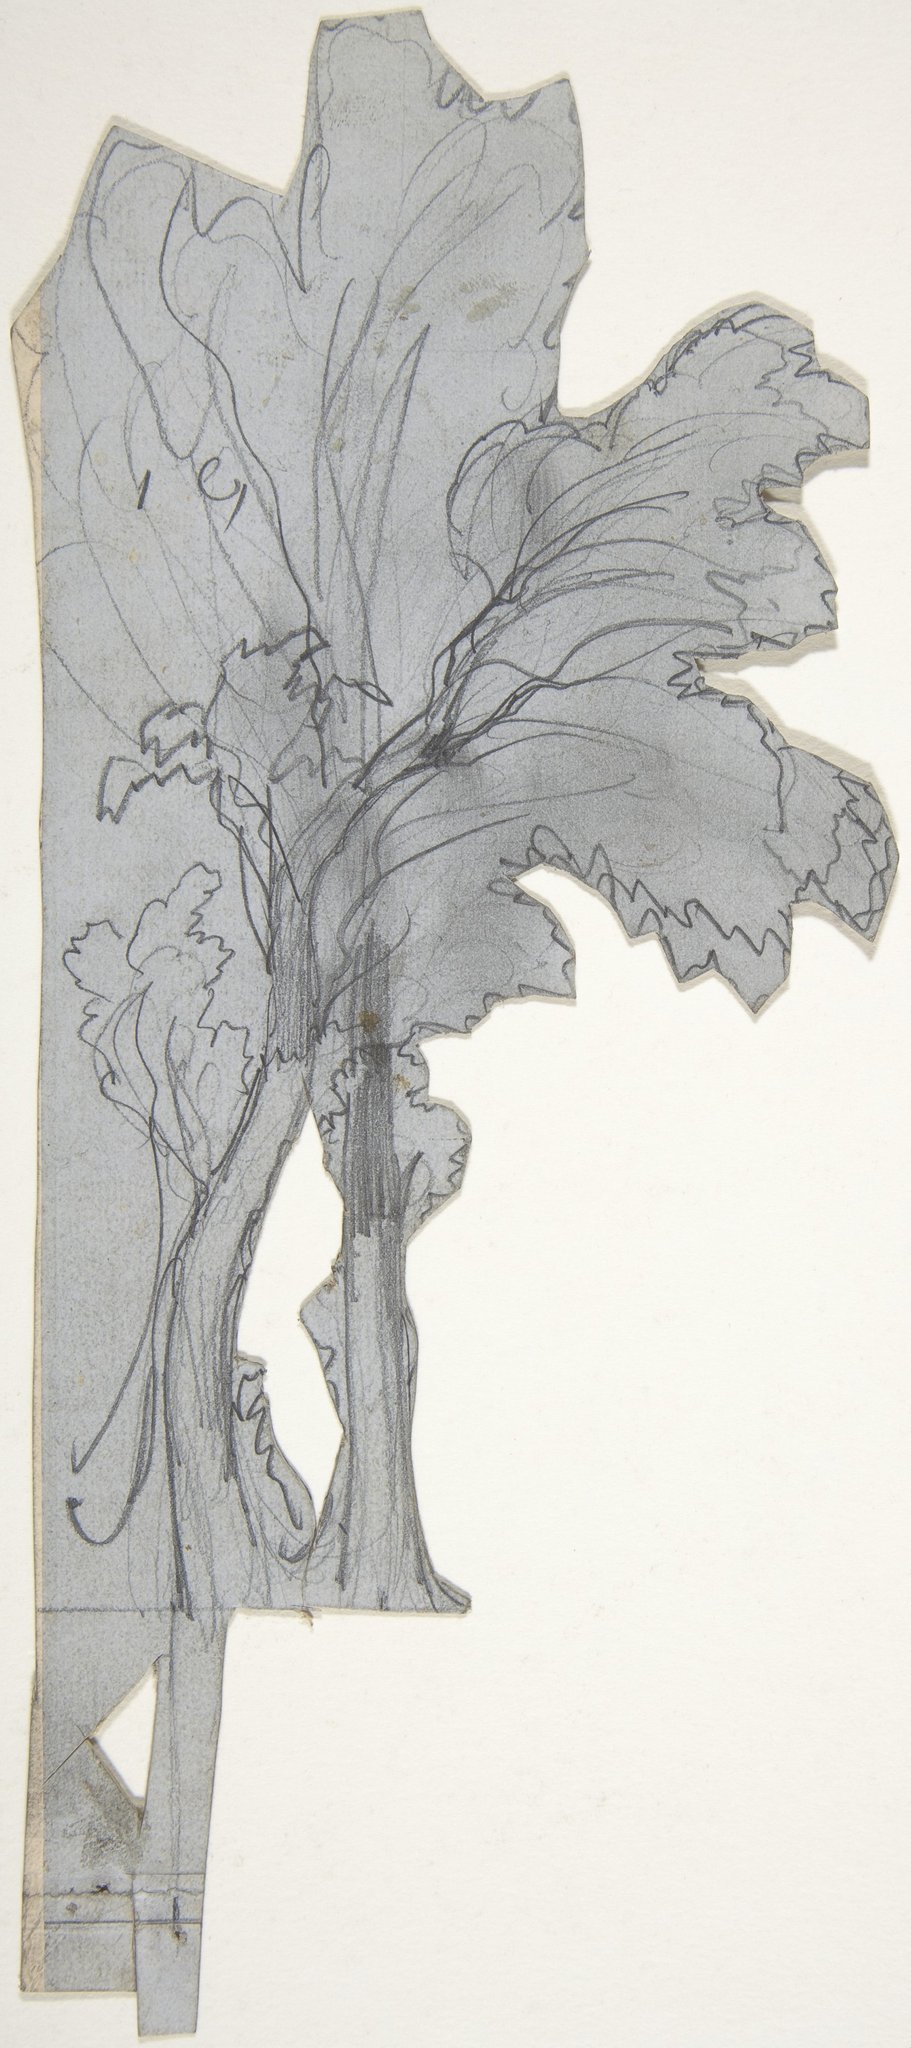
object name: drawing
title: Design for a Stage Set at the Opéra, Paris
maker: eugène cicéri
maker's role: artist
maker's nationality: french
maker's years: 1813-1890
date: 1830-1890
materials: graphite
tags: trees,stage design